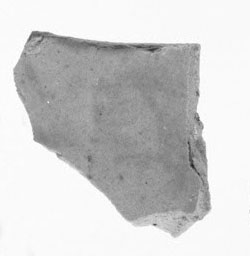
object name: shard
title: Shard (Study Collection)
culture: chinese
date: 1644-1911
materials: ceramic, glaze